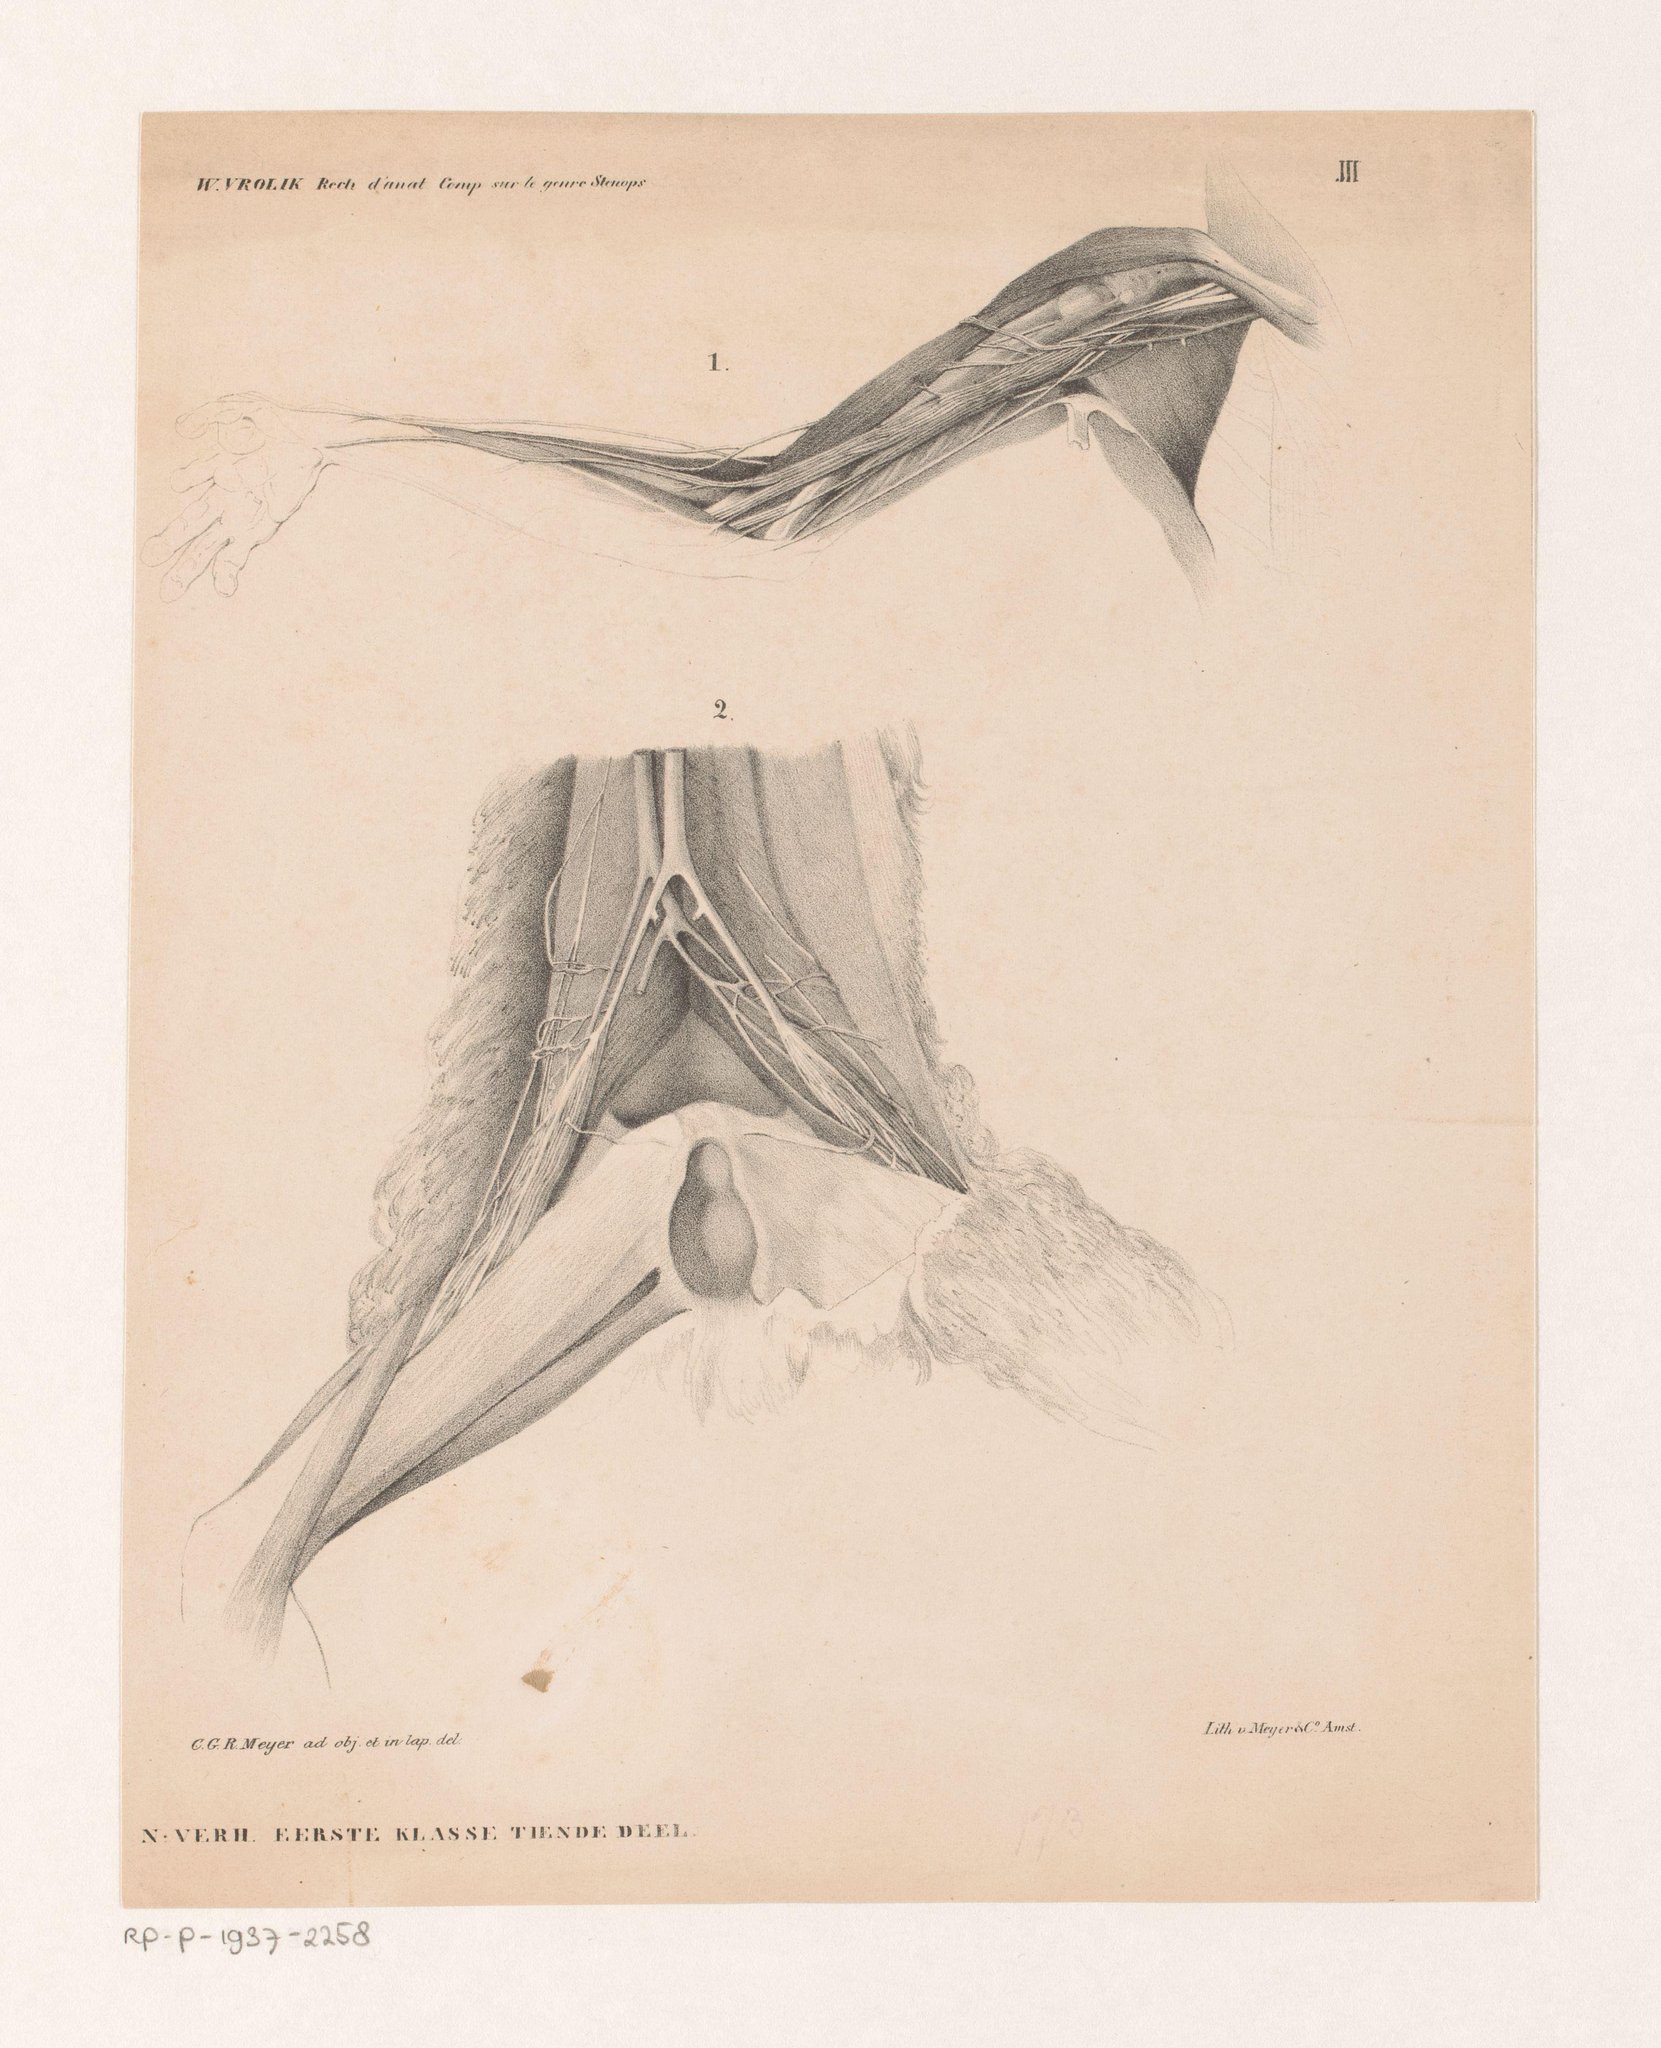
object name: print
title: Anatomieën van een Lori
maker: christian gerhard rudolf meijer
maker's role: print maker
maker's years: 1806-1875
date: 1843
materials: paper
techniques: lithograph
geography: amsterdam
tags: anatomical model of the veins, vein-man, monkeys, apes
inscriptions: collector's mark: Lugt 2760, collector's mark: Lugt 2228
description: Gepubliceerd in: Vrolik, W. Recherches d'anatomie comparée sur le genre Stenops d'Illiger in: Nieuwe Verhandelingen der Eerste Klasse van het Koninklijk-Nederlandsch Instituut van Wetenschappen, Letterkunde en Schoone Kunsten. Amsterdam, C. G. Sulpke: 1843, afl. 2.